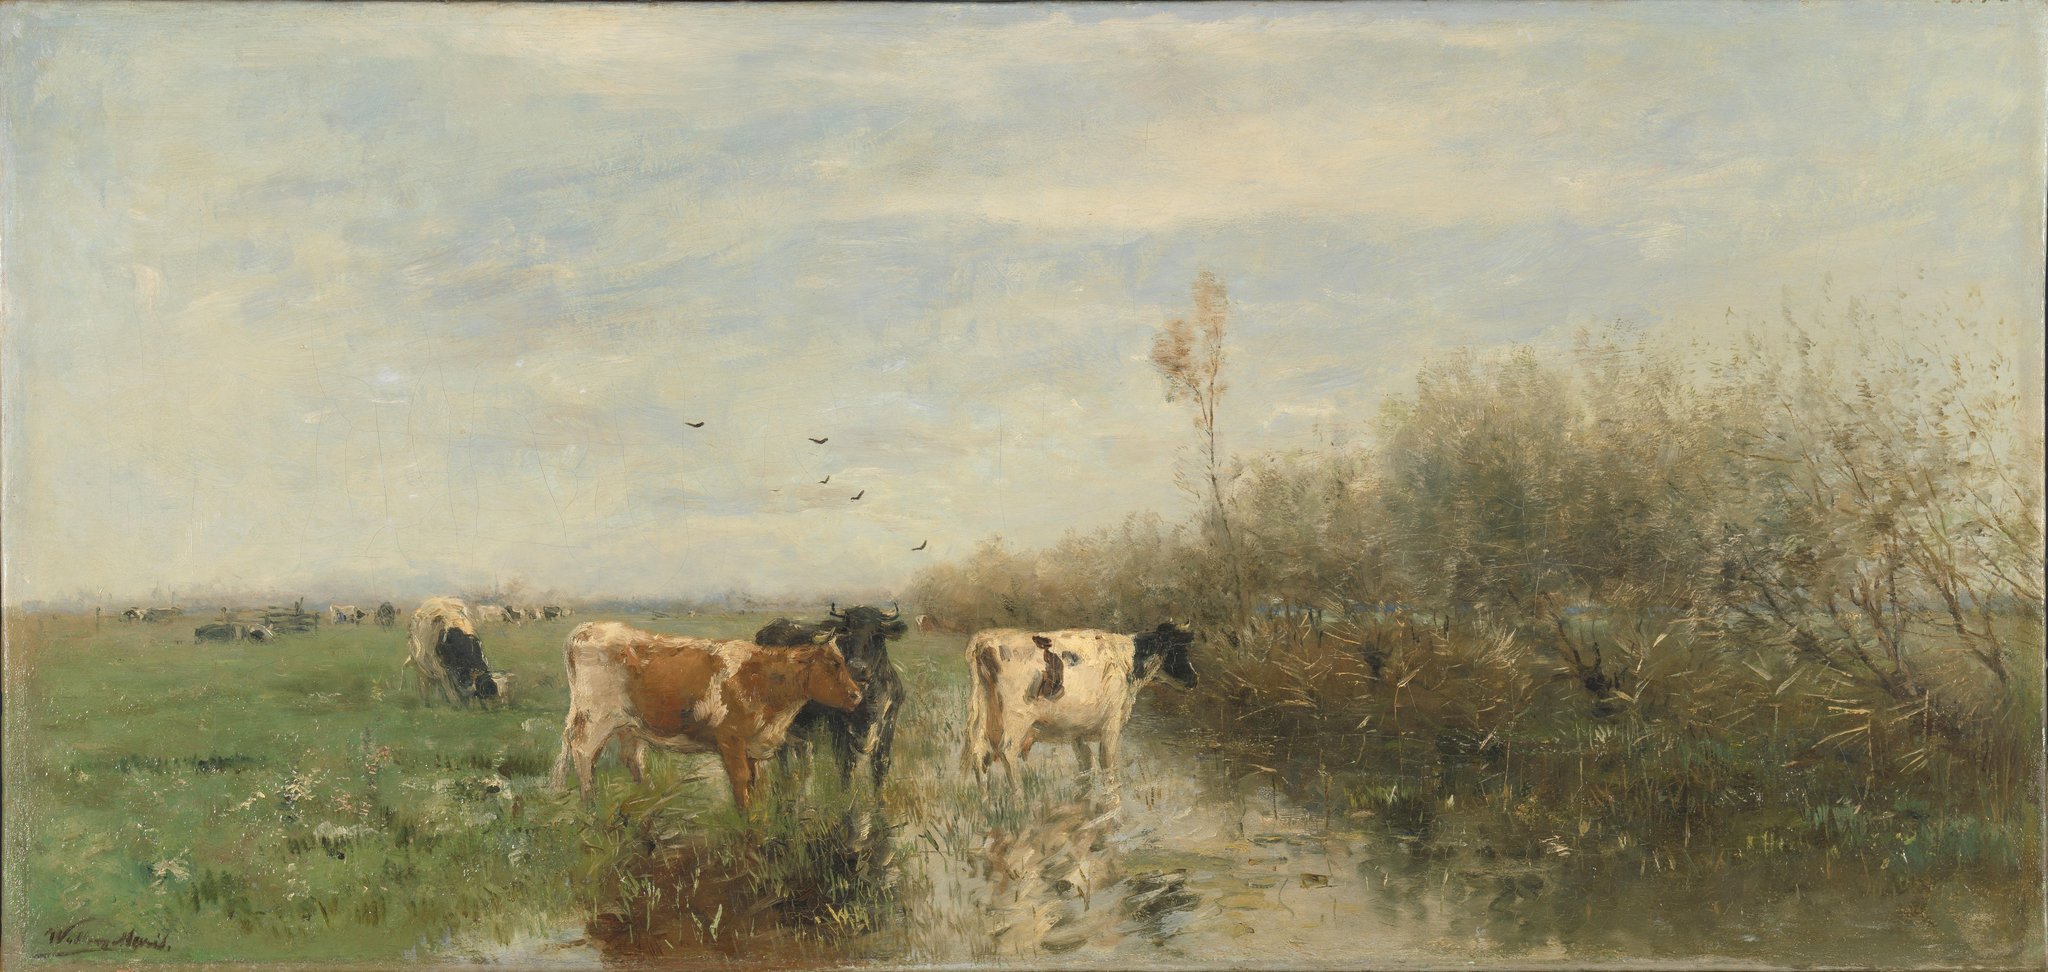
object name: painting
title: Cows in a Soggy Meadow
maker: willem maris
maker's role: draughtsman, painter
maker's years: 1844-1910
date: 1860-1900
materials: canvas, oil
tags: swamp, inland marsh, fens, cow, meadow, pasture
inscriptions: signature: ‘Willem Maris’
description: Landschap met grazende koeien in een drassig weiland.